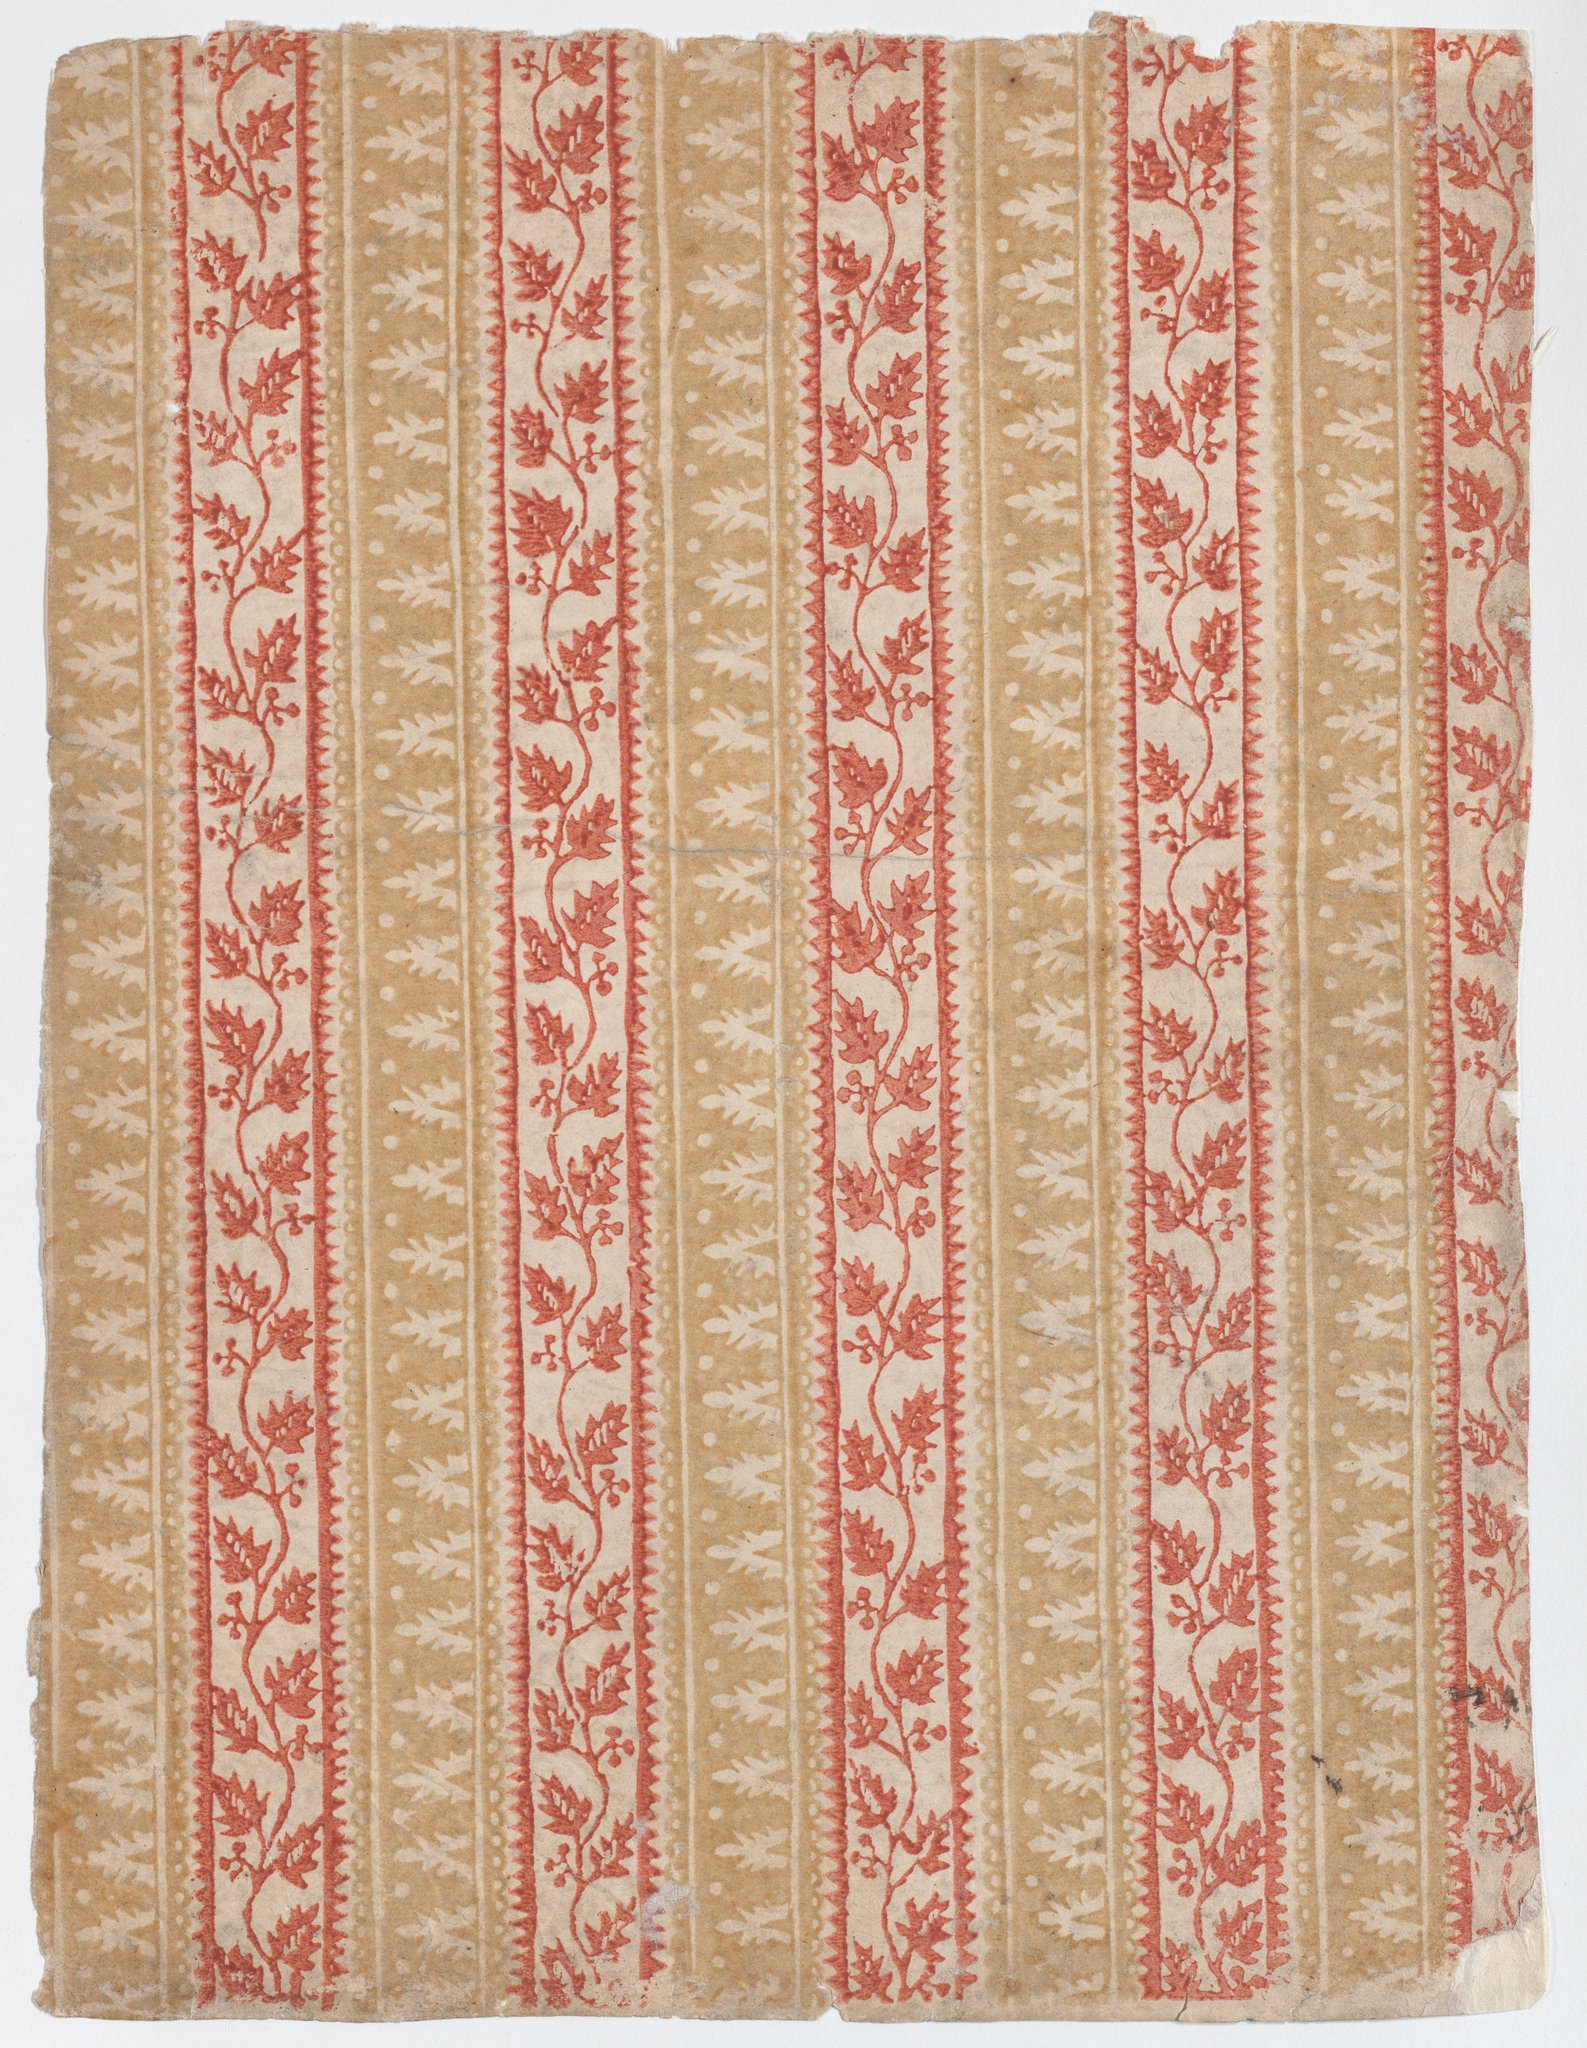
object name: print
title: Sheet with five borders with abstract and floral designs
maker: Anonymous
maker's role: artist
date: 1801-1900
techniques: relief print